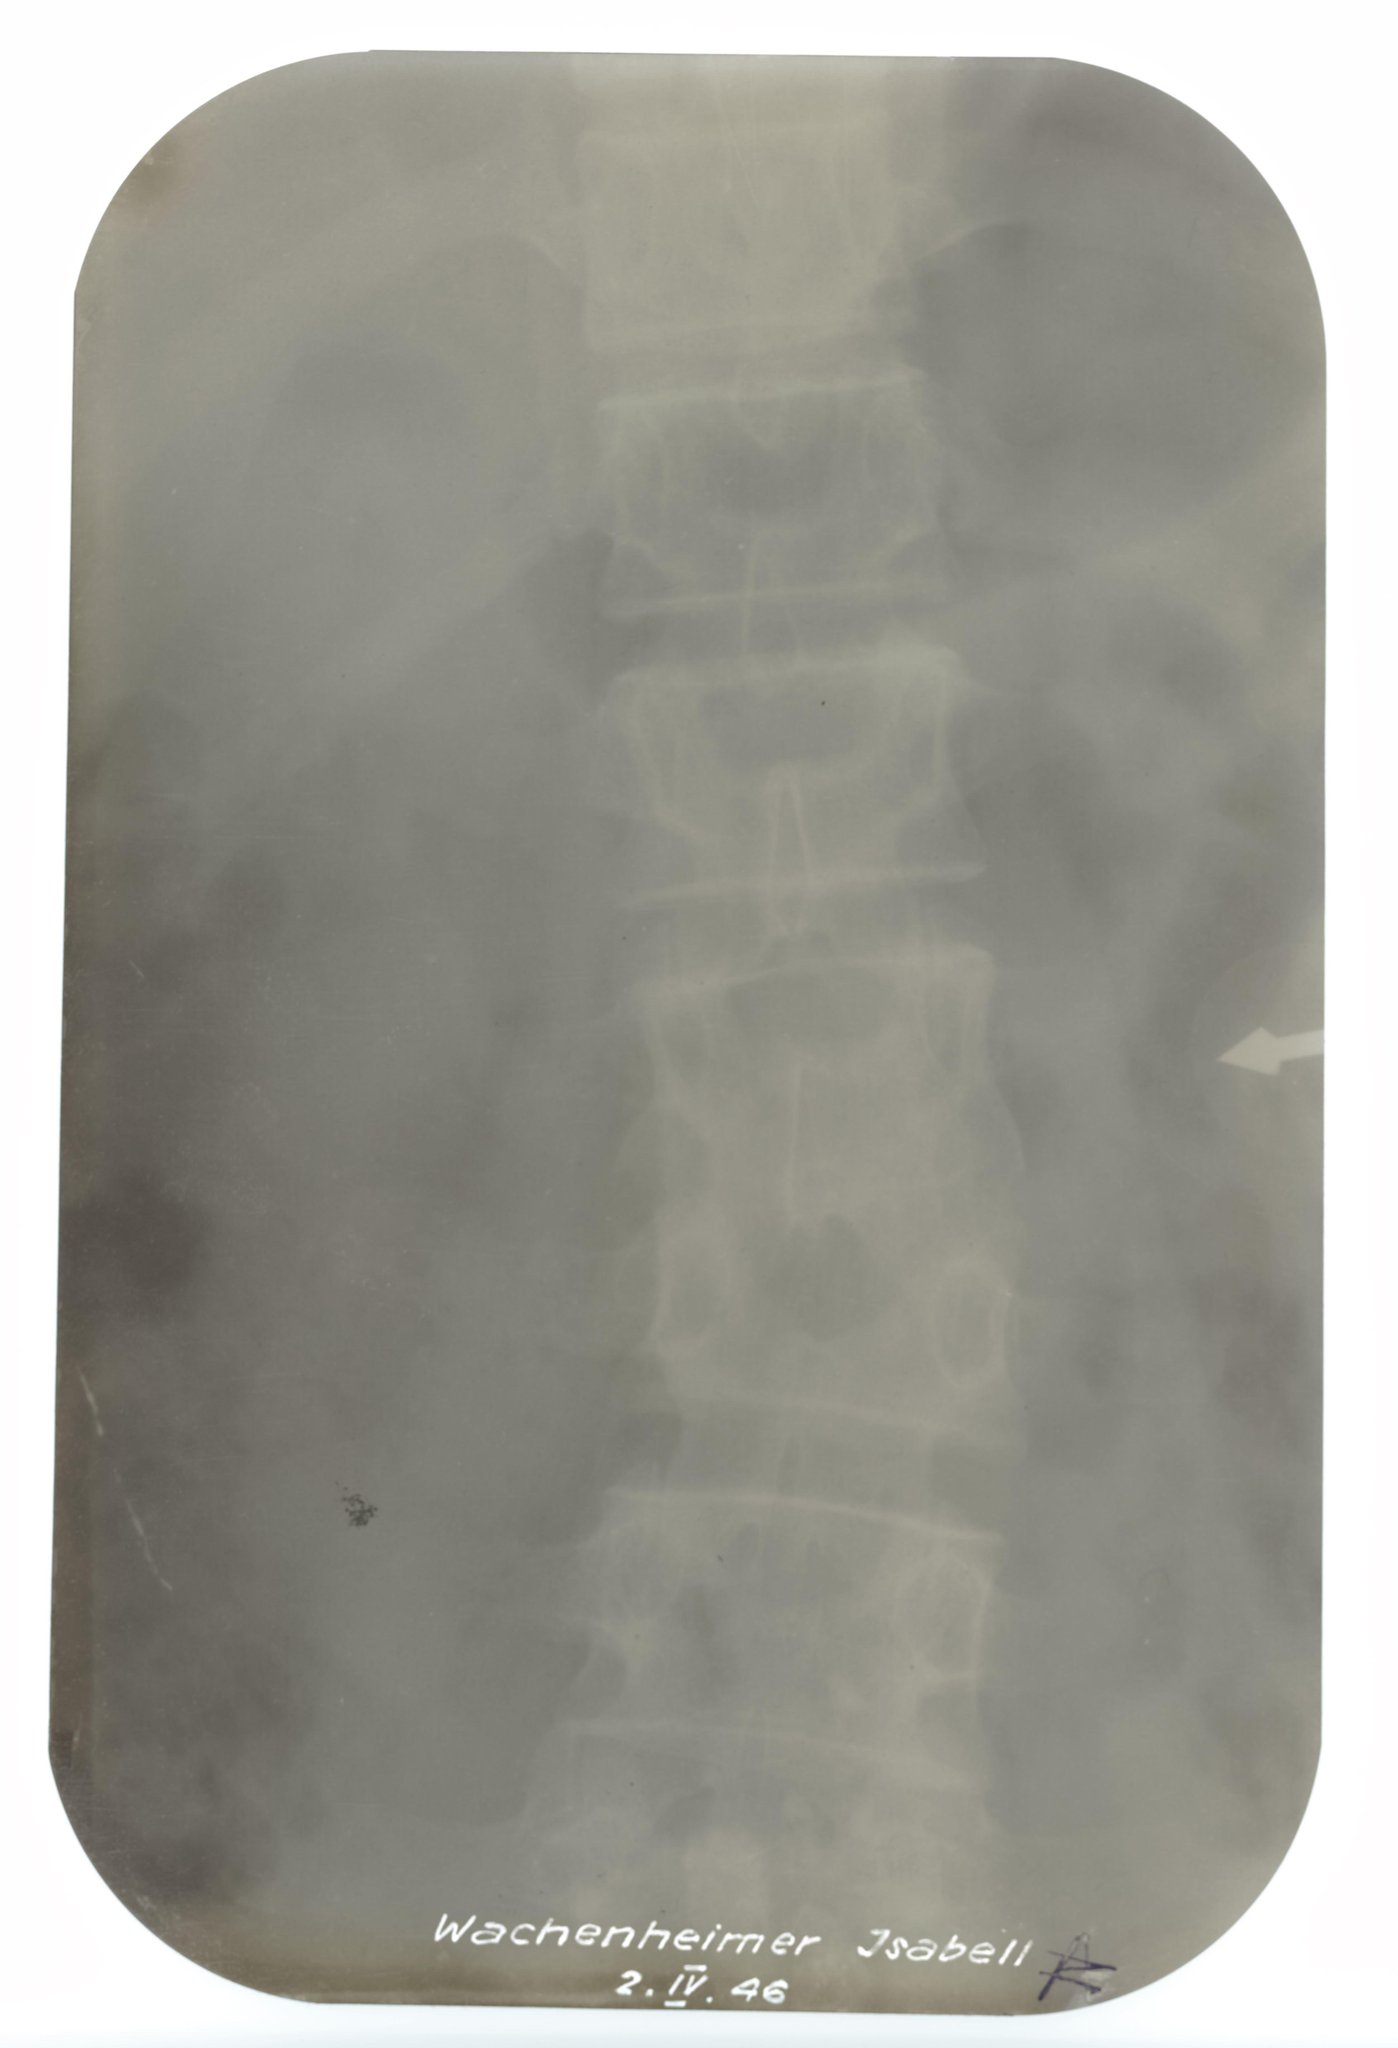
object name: photograph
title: Röntgenfoto van de met TBC geïnfecteerde ruggenwervel van Isabel Wachenheimer, gedateerd op 2 april 1946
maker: Anonymous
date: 1946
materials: photographic support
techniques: gelatin silver print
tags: leiden, isabel wachenheimer-elon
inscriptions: date: ‘Wachenheimer Isabell 2.4.46’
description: Röntgenfoto van de met TBC geïnfecteerde ruggenwervel van Isabel Wachenheimer.